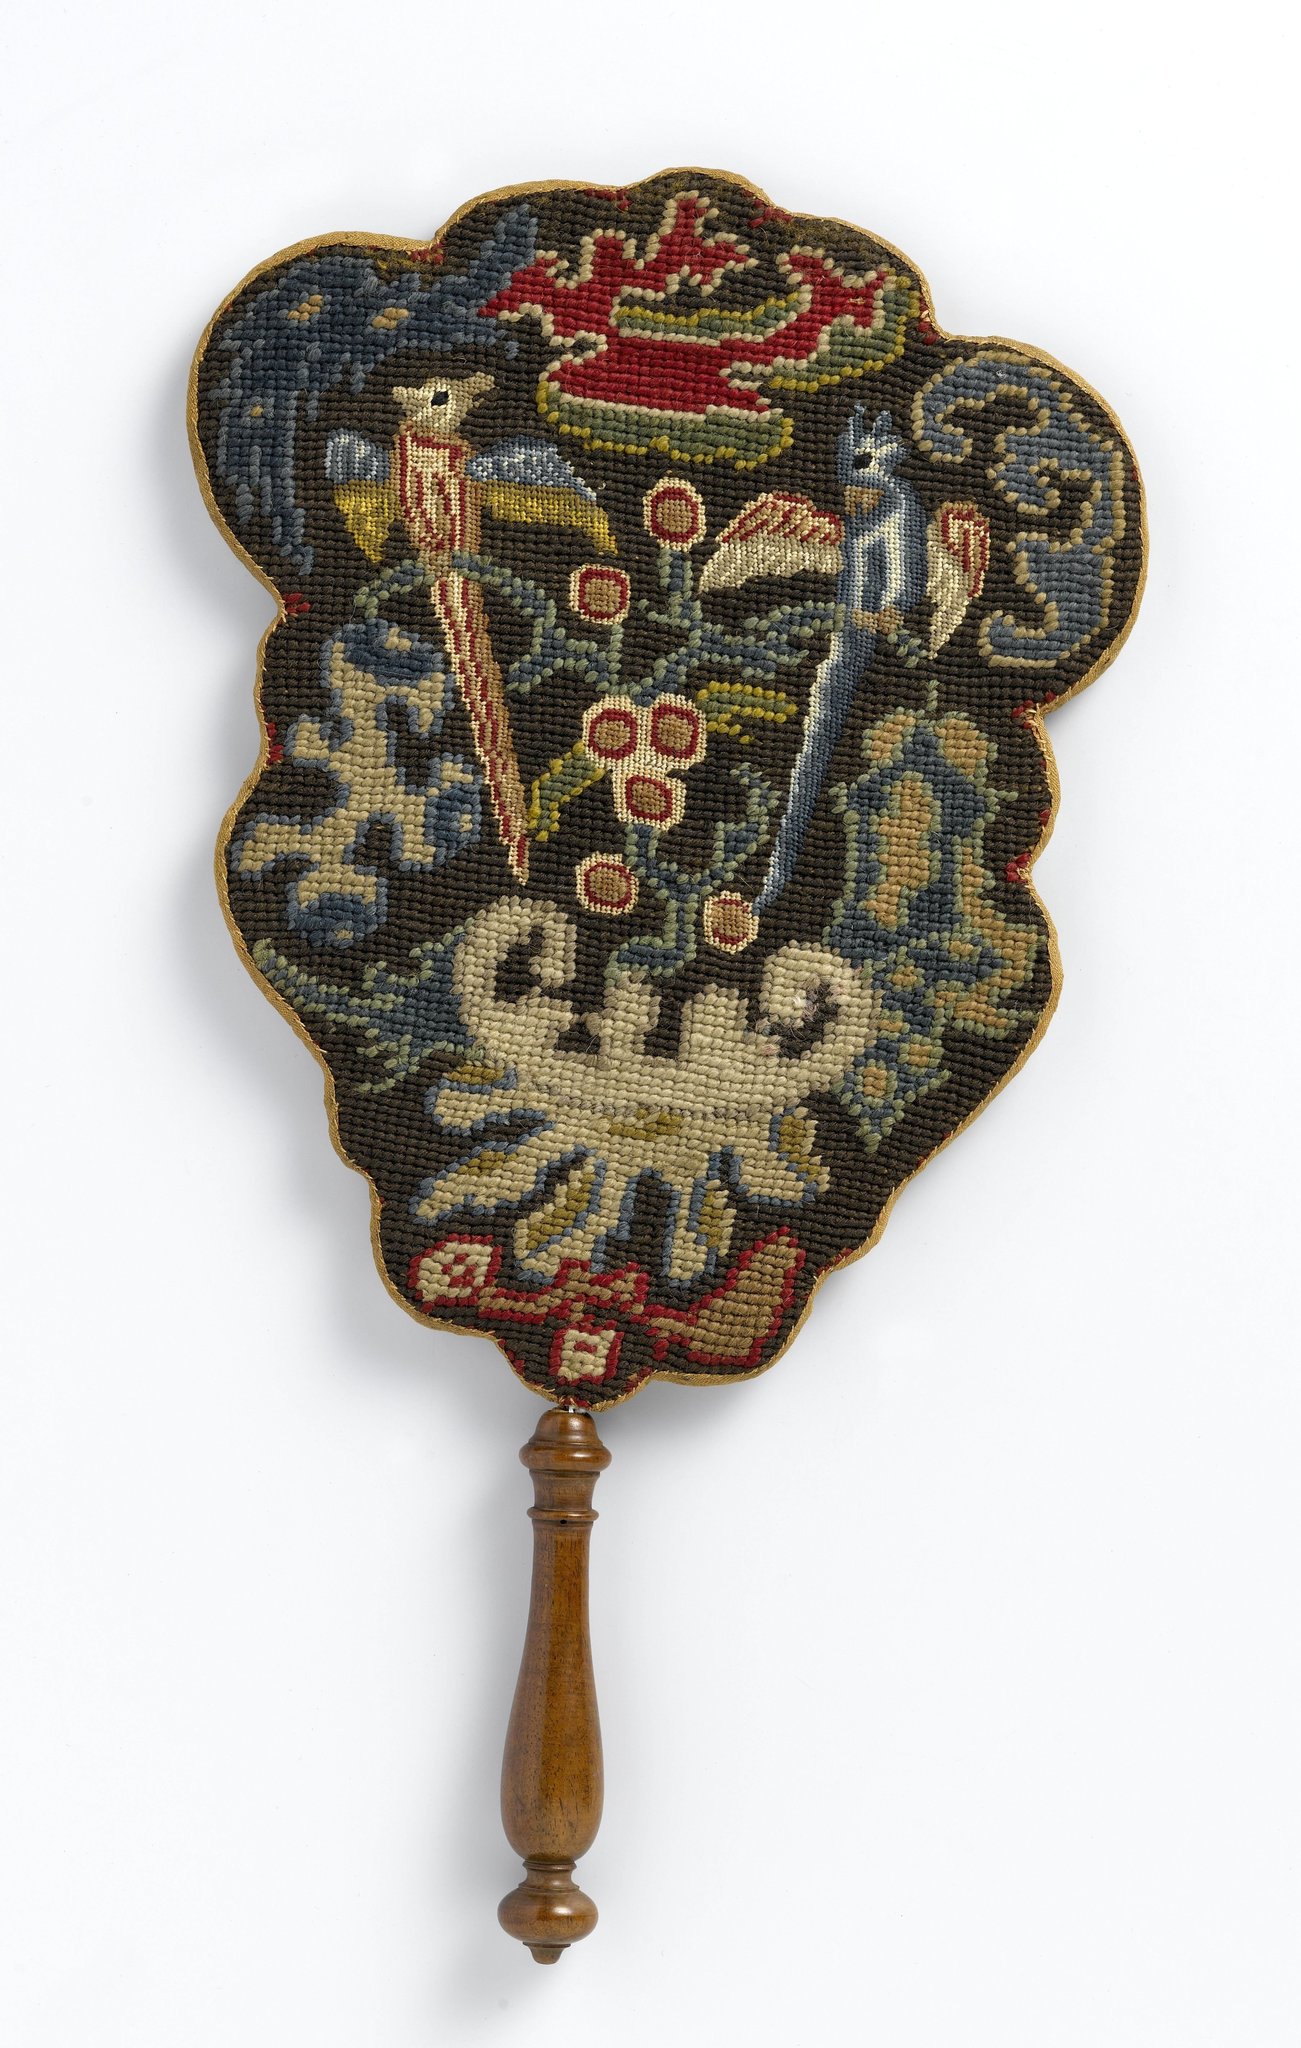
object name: fan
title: Vuurscherm van linnen, gespannen over geschulpt, houten(?) frame, aan de voorkant geborduurd met veelkleurige wol en aan de achterkant bedrukt met een putto met bloemenschaal, gemonteerd op notenhouten stok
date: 1688-1720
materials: linen, ink, wood, wool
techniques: embroidered, printing, tensioning, turning, weave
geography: northern netherlands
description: Het onregelmatig geschulpte scherm is aan de voorkant geborduurd met veelkleurige wol in petit-point en gros-point. Centraal in het asymmetrisch opgebouwde patroon zitten twee elkaar toegewende vogels op een tak, temidden van bloem- en bladmotieven. De lange staarten en de barokke opbouw van het patroon zijn ongebruikelijk en vooralsnog niet terug te voeren op voorbeelden uit patroonboeken. De notenhouten stok is vanuit een nodus aan het scherm gezet. De achterkant van het scherm is bedrukt met een beige putto met grijze vleugels, die een schaal met gekleurde bloemen boven zijn hoofd houdt. De bloemenmand zonder de putto is terug te vinden in een album met prenten van Johan Teyler in het Rijksprentenkabinet (inv. RP-P-1955-195), maar in een uitgebreider album in het British Museum, London (inv. 1871-12-9-5027(25)) bevindt zich de gehele voorstelling van putto en mand.